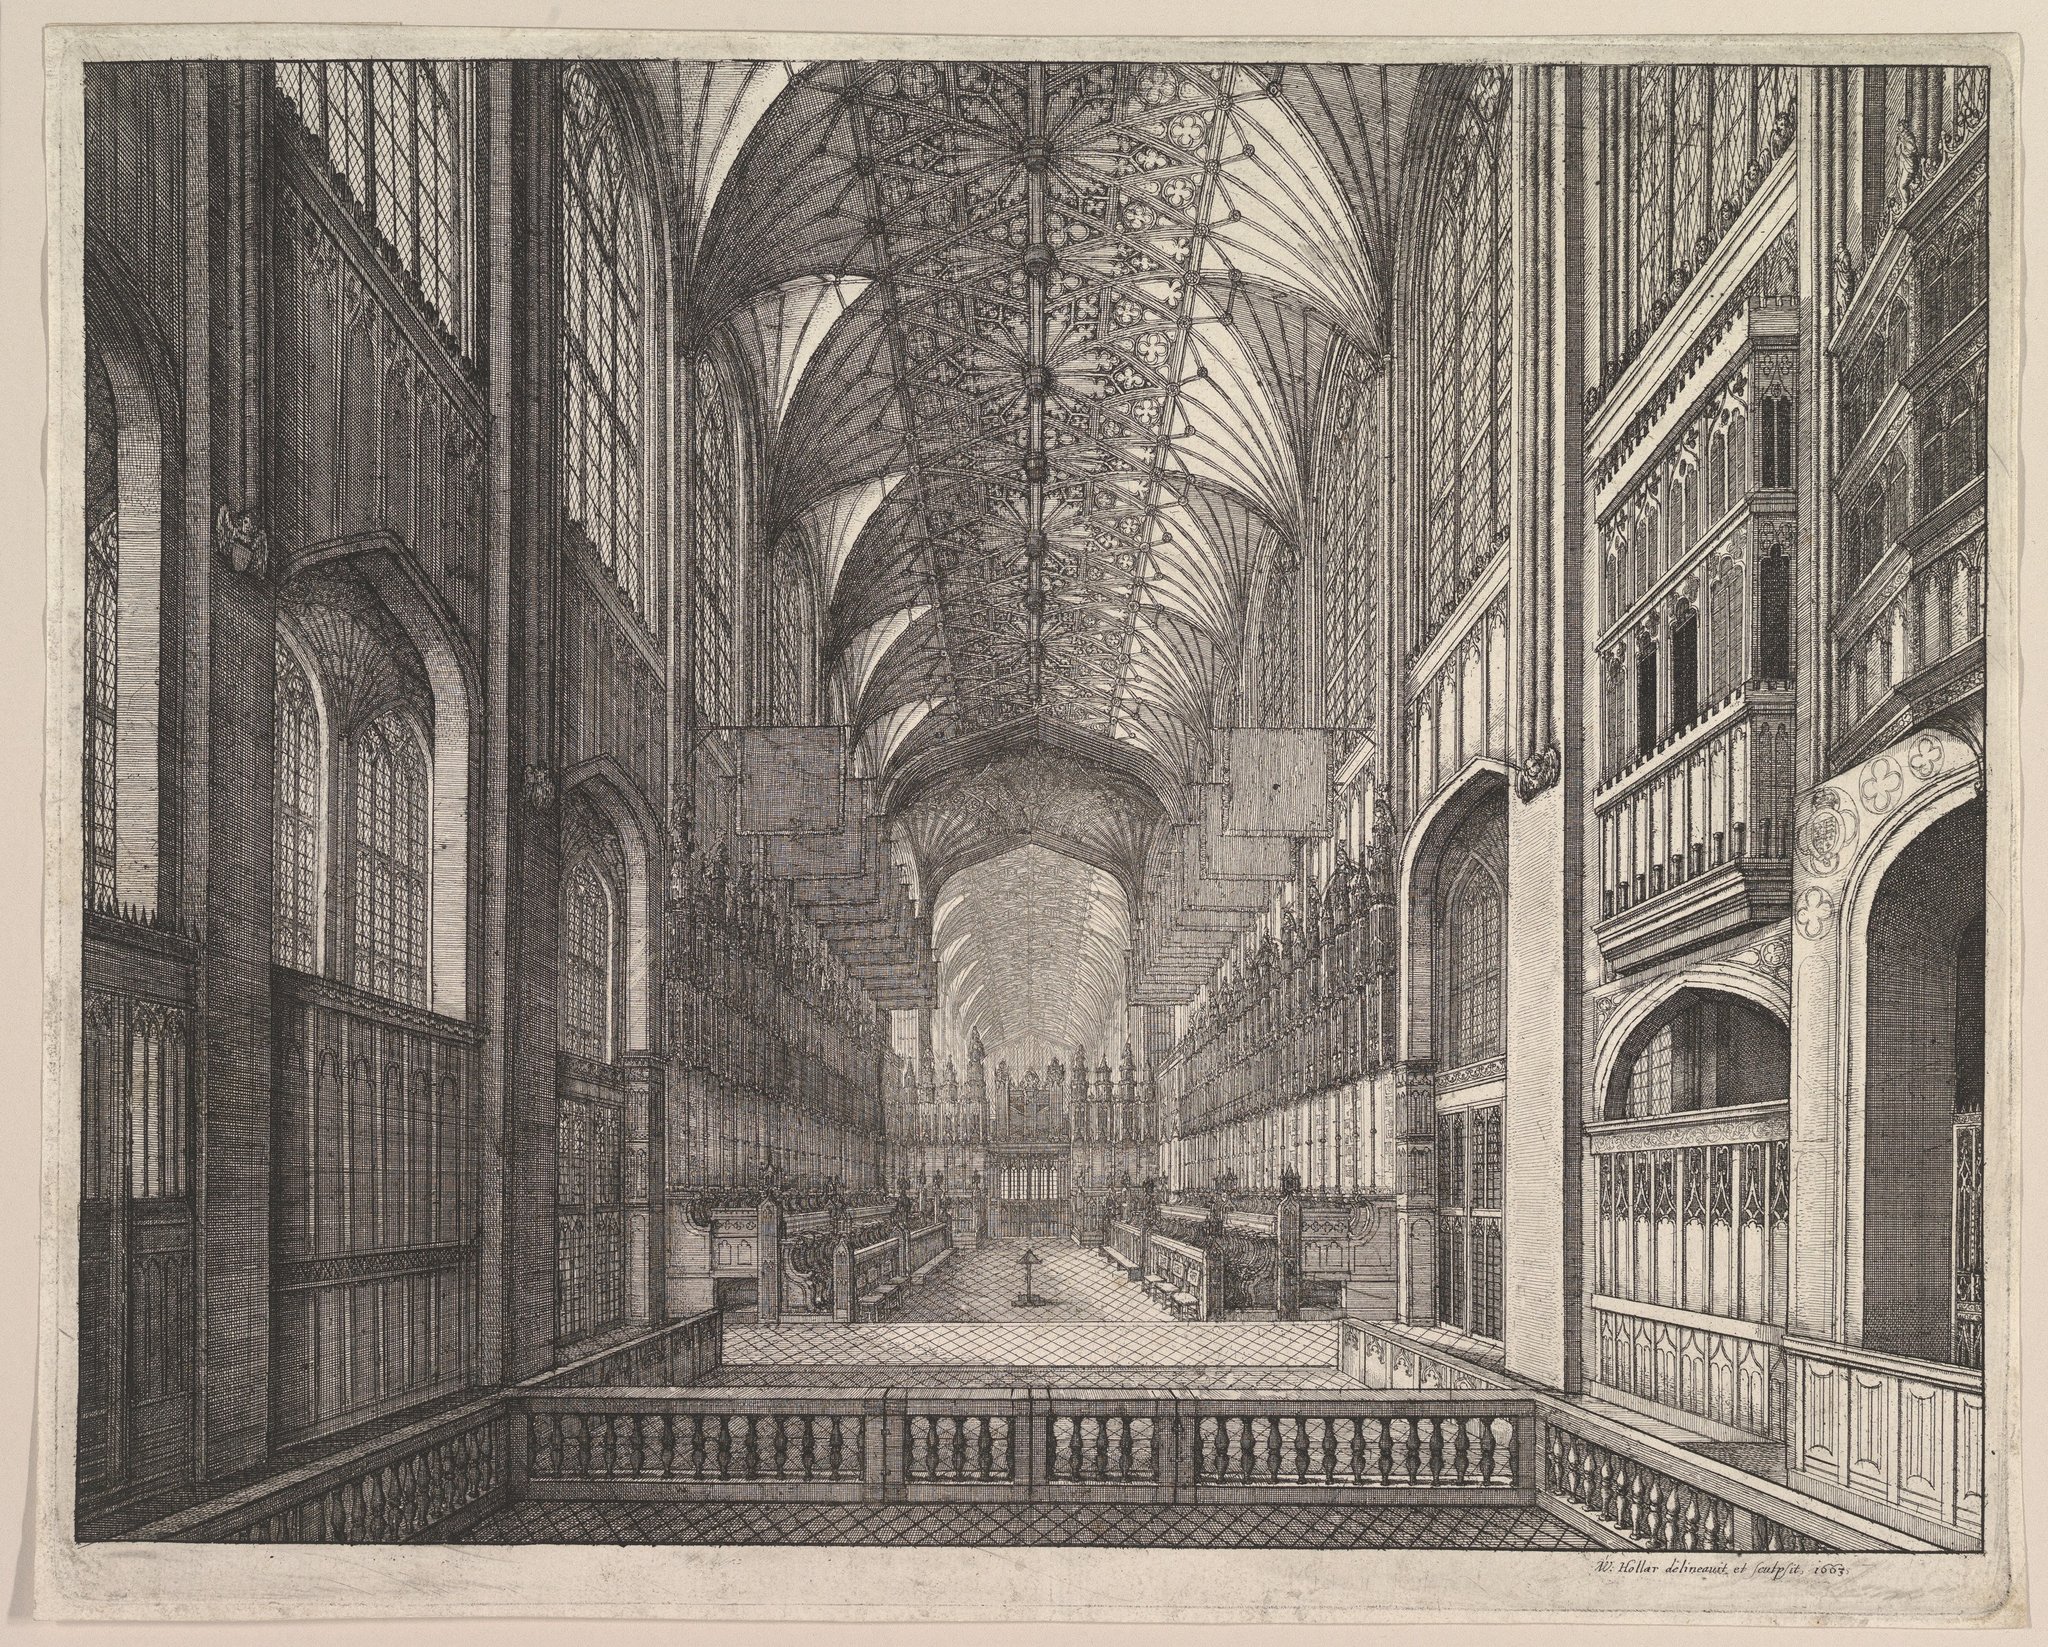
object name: print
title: St. George's Chapel Choir, Windsor (from Elias Ashmole's "The Order of the Garter," 1672)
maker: wenceslaus hollar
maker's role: artist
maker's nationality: bohemian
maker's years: 1607-1677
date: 1663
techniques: etching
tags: churches